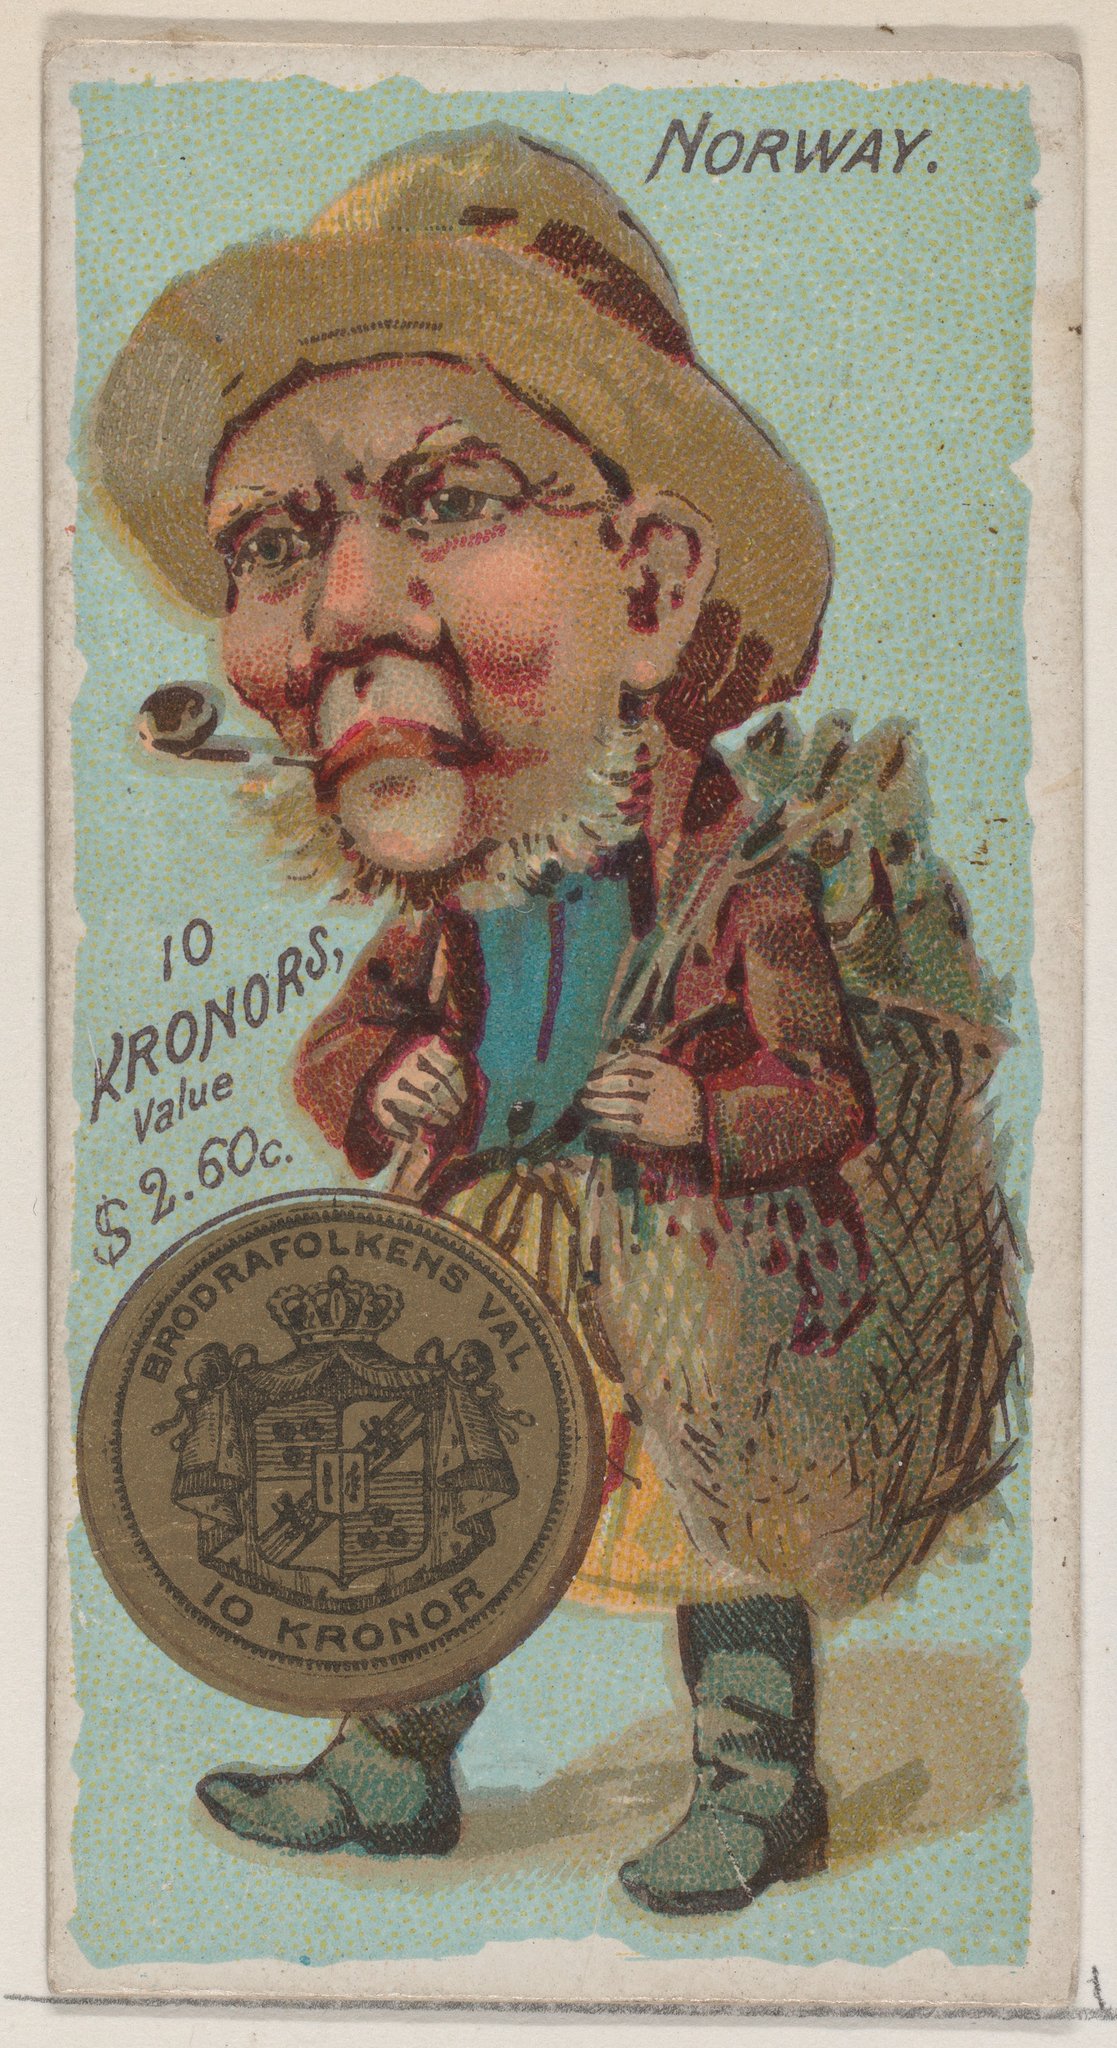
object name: print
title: Norway, 10 Kronors, from the series Coins of All Nations (N72, variation 2) for Duke brand cigarettes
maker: w. duke, sons & co.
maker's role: publisher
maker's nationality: american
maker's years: 1870-1920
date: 1889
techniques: color lithograph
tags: men,smoking,coins